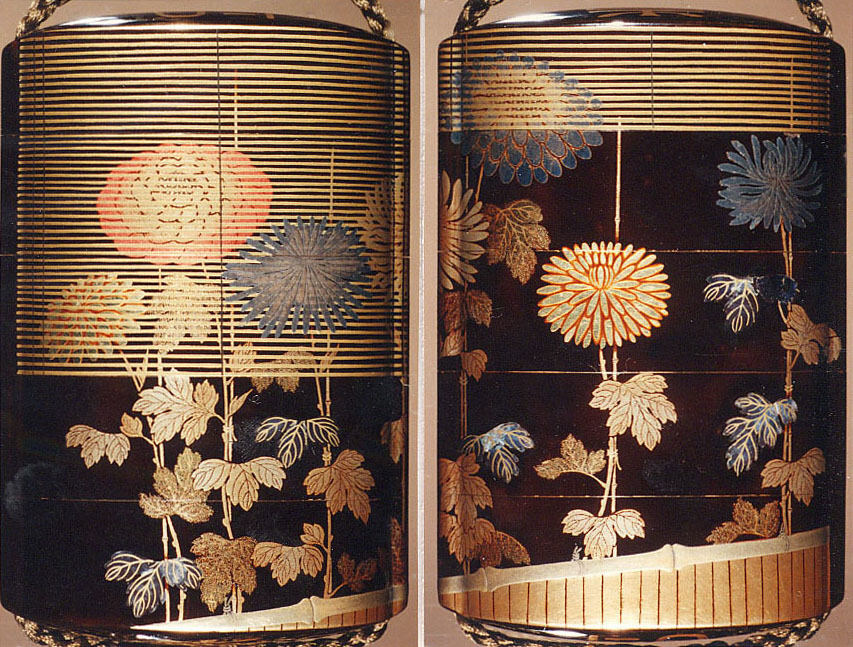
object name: inrō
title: Case (Inrō) with Design of Chrysanthemums Beneath Bamboo Blinds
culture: japanese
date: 1801-1900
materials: gold, lacquer, silver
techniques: fundame, roiro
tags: flowers